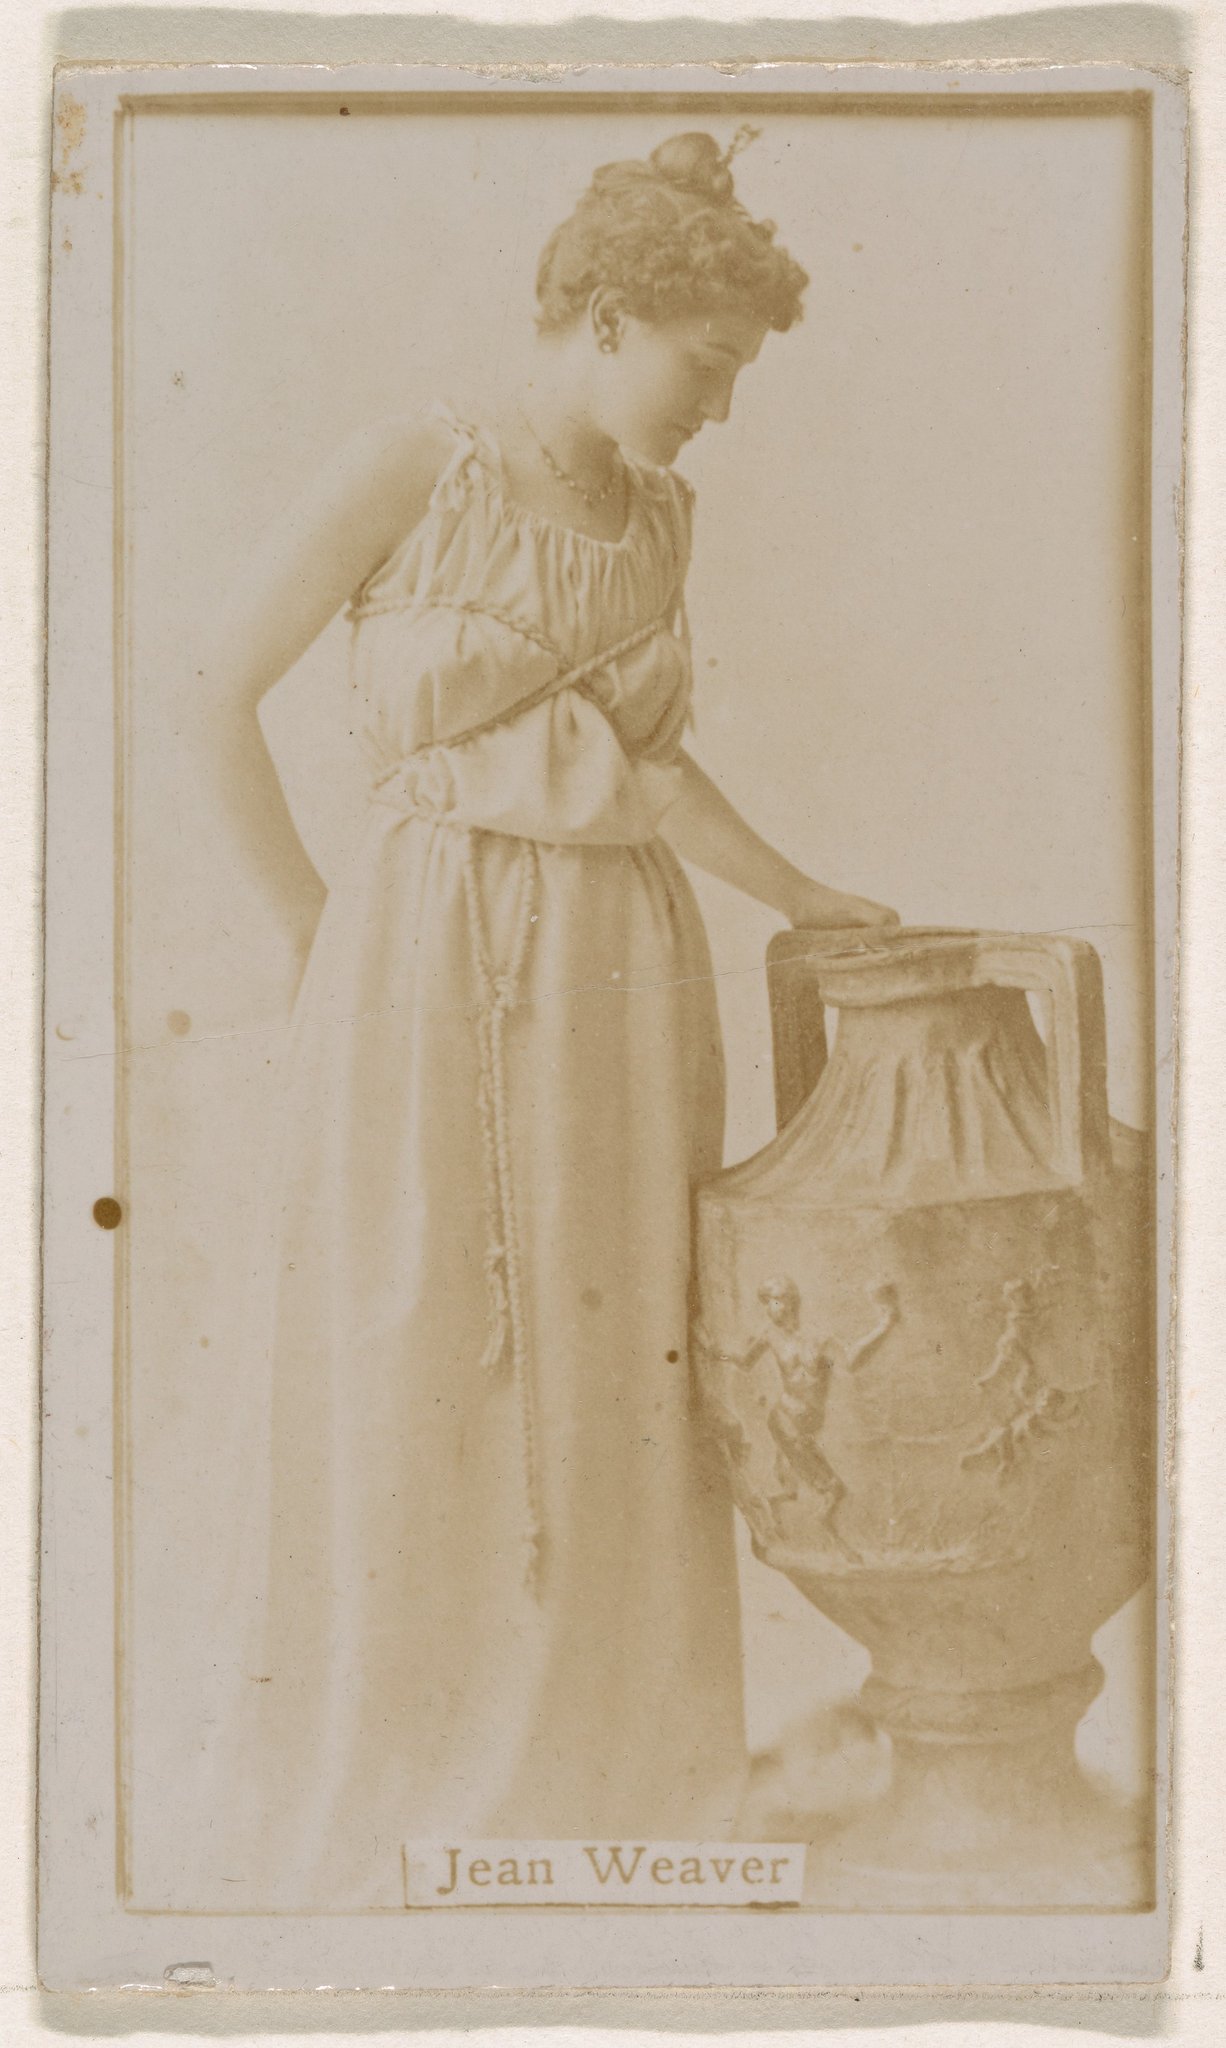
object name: photograph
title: Jean Weaver, from the Actresses series (N245) issued by Kinney Brothers to promote Sweet Caporal Cigarettes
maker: kinney brothers tobacco company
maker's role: publisher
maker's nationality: american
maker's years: 1869-2011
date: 1890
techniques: albumen silver print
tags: women,actresses